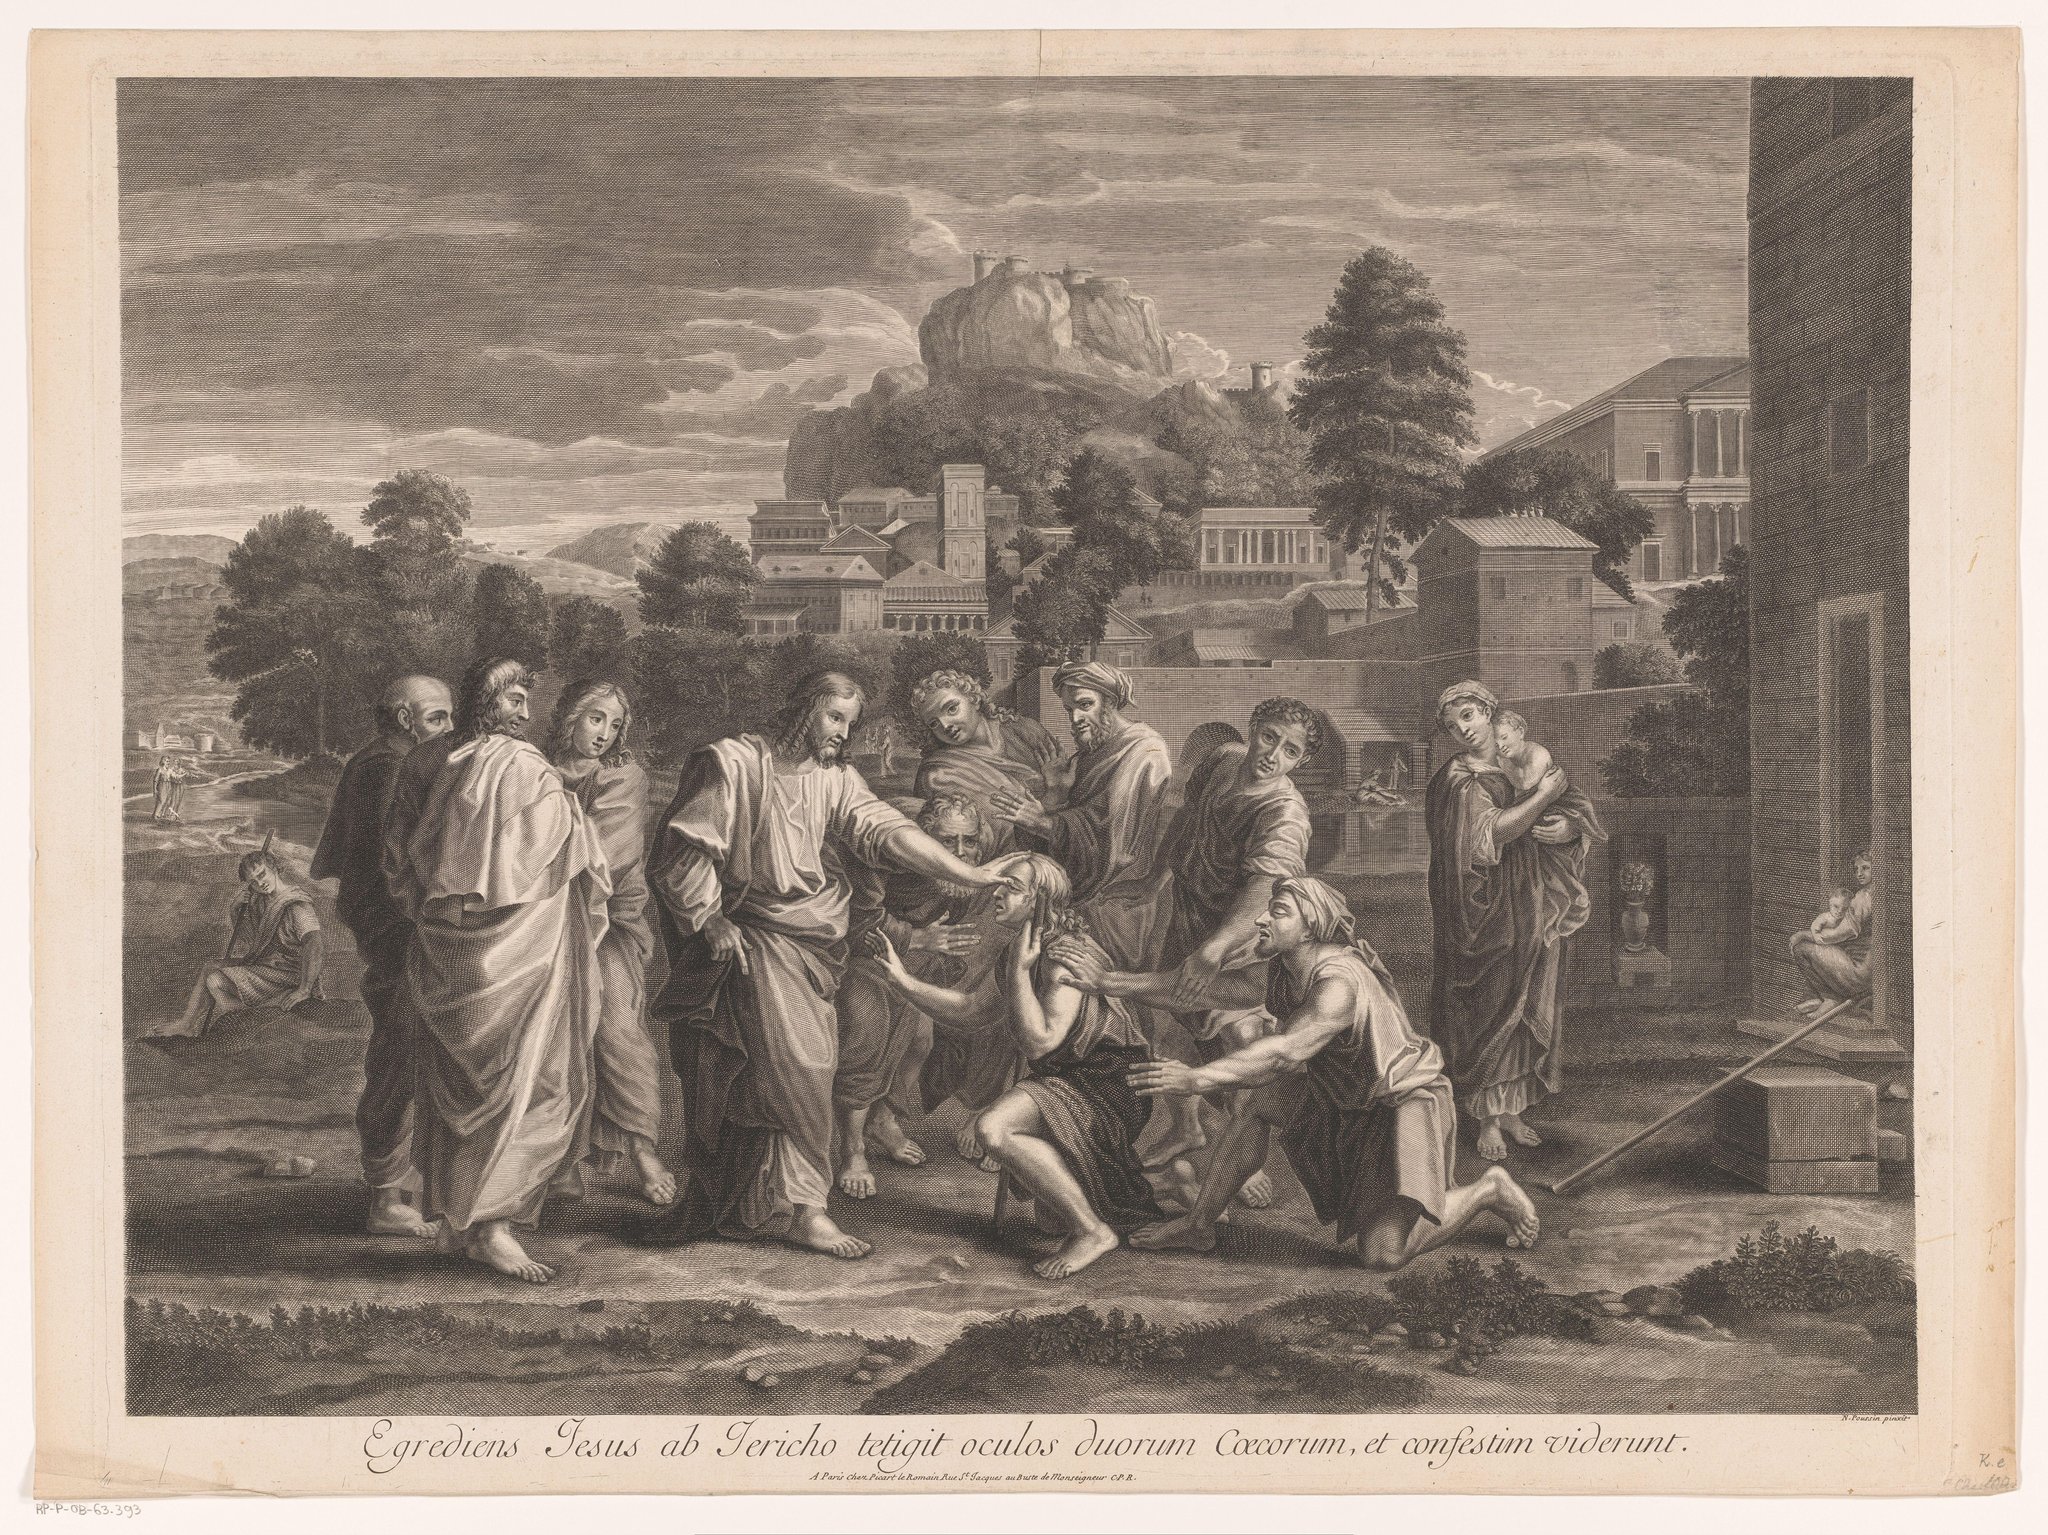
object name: print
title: Christus geneest twee blinden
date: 1642-1721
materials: paper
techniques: engraving, etching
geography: france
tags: healing of two blind men, or one (bartimaeus), sitting near jericho (matthew 20:29-34; mark 10:46-52; luke 18:35-43)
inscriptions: collector's mark: Lugt 240